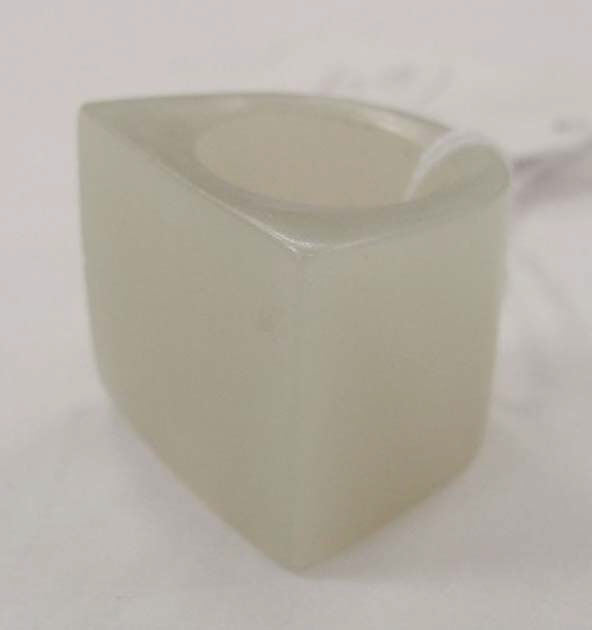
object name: ring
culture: chinese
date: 1801-1900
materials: jade